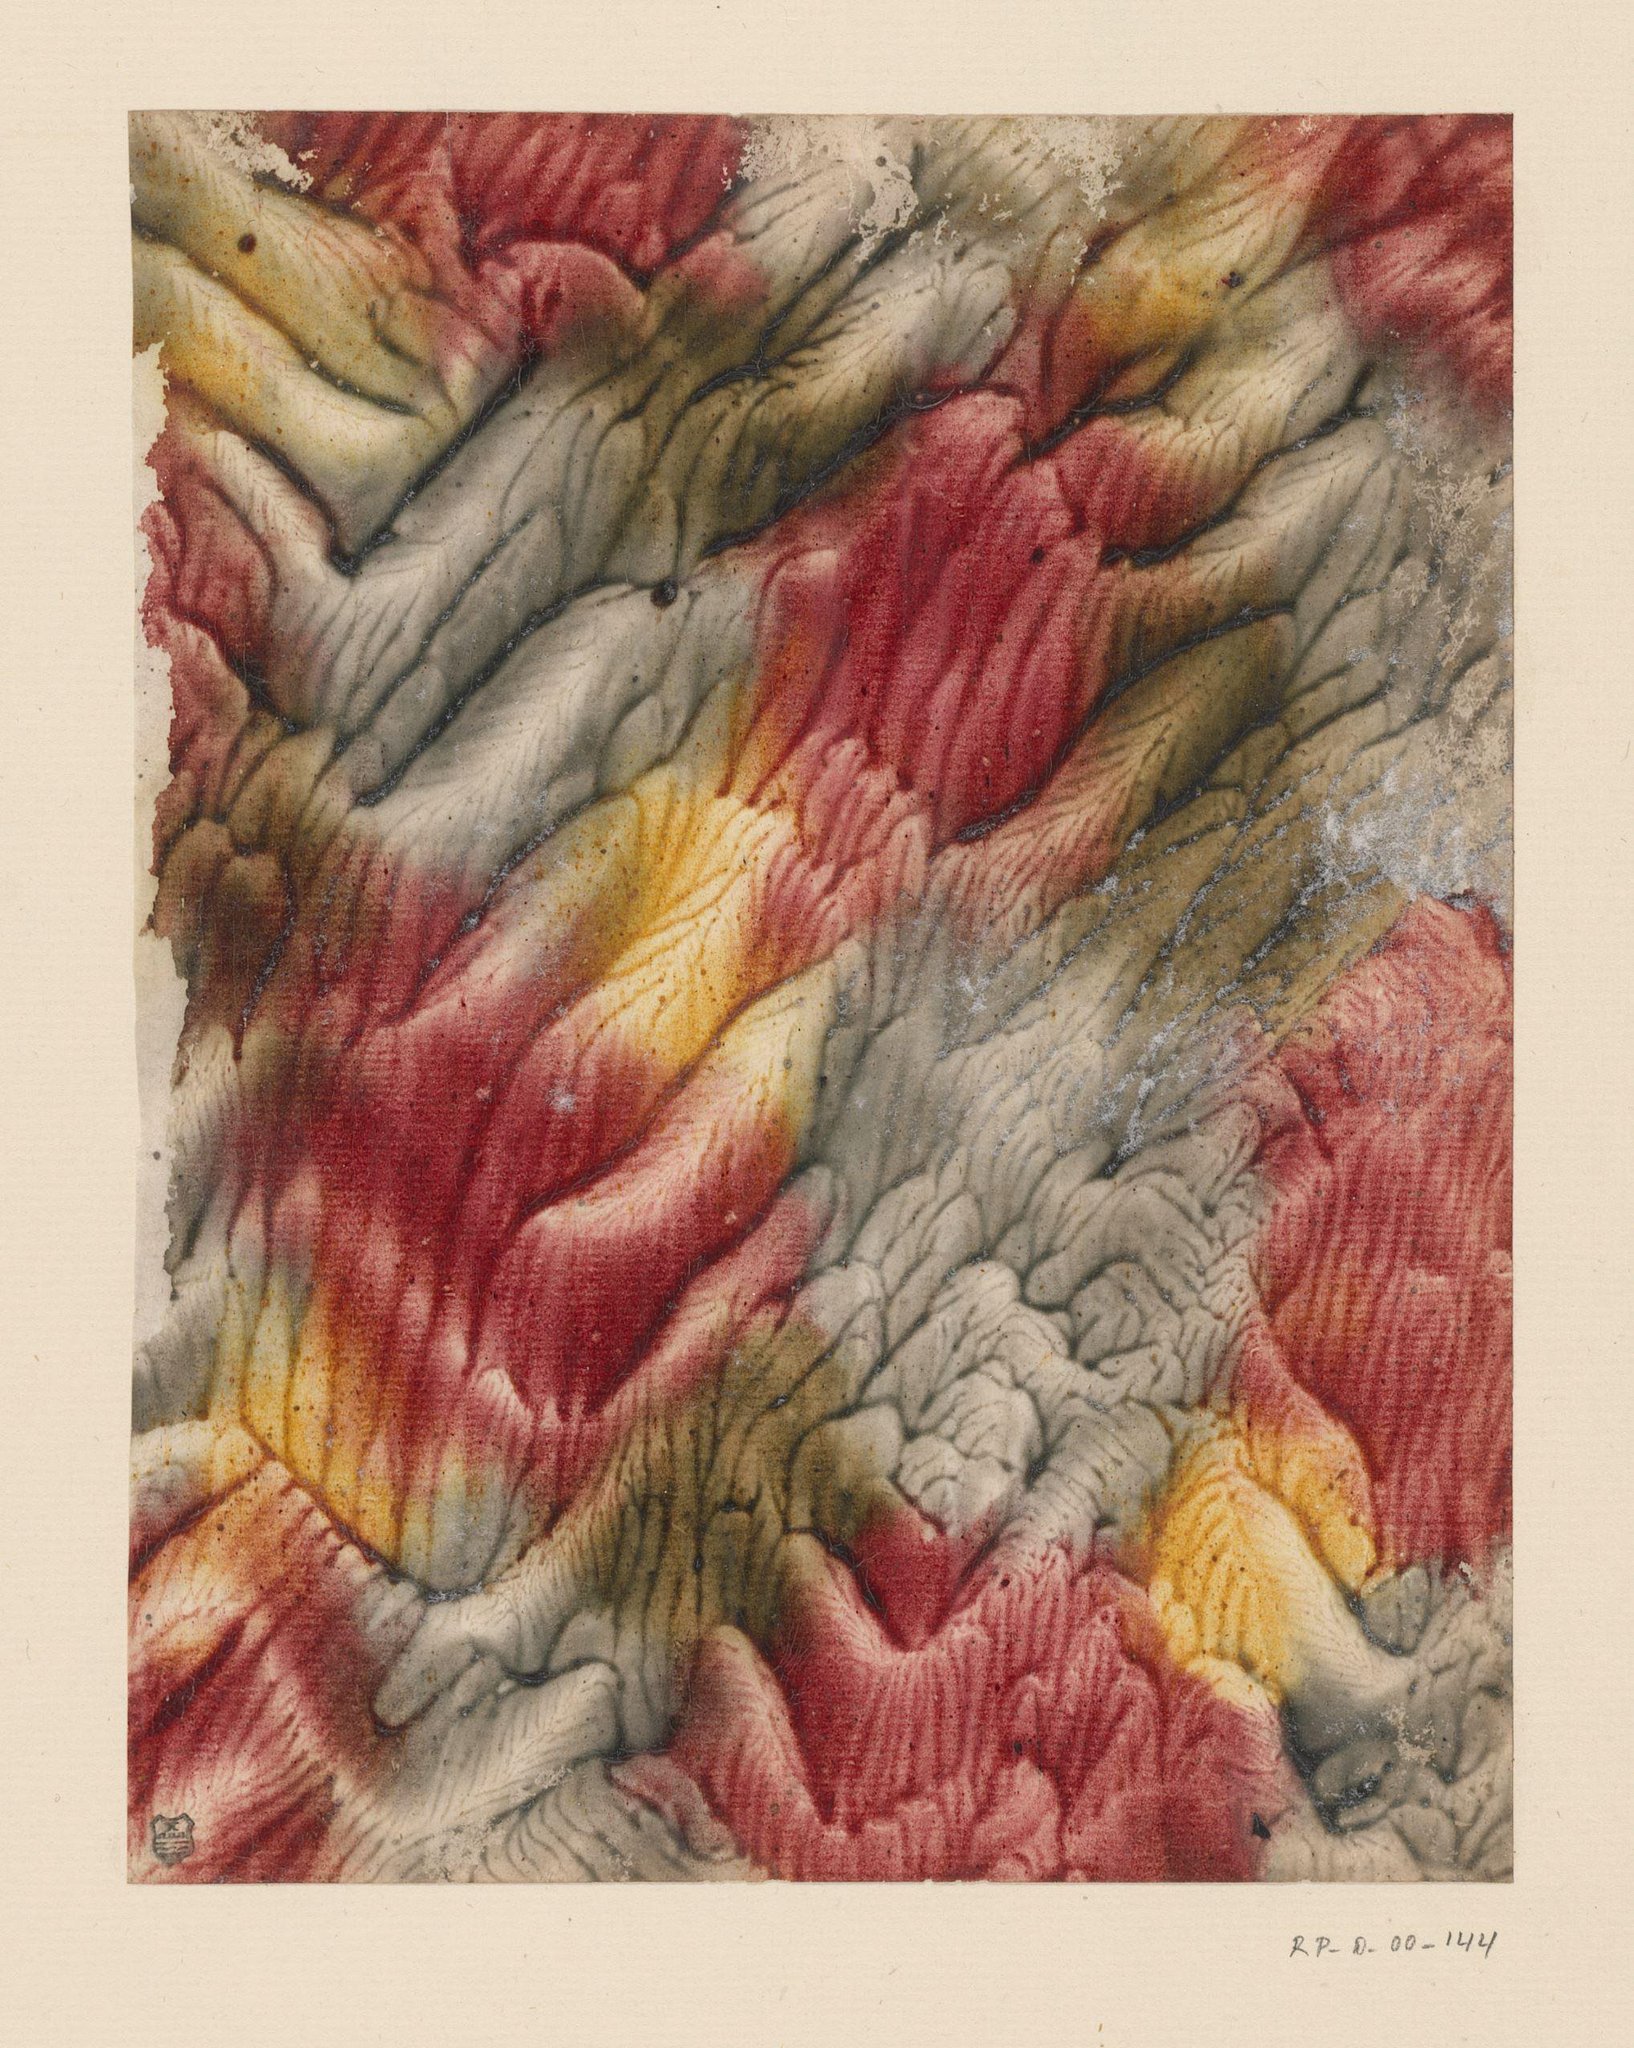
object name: paste paper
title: Geaderd stijfselverfpapier met kleurvlekken van rood, geel, groen en grijs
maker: Anonymous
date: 1700-1900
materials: paper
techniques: starch dyeing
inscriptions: collector's mark: Lugt 2760